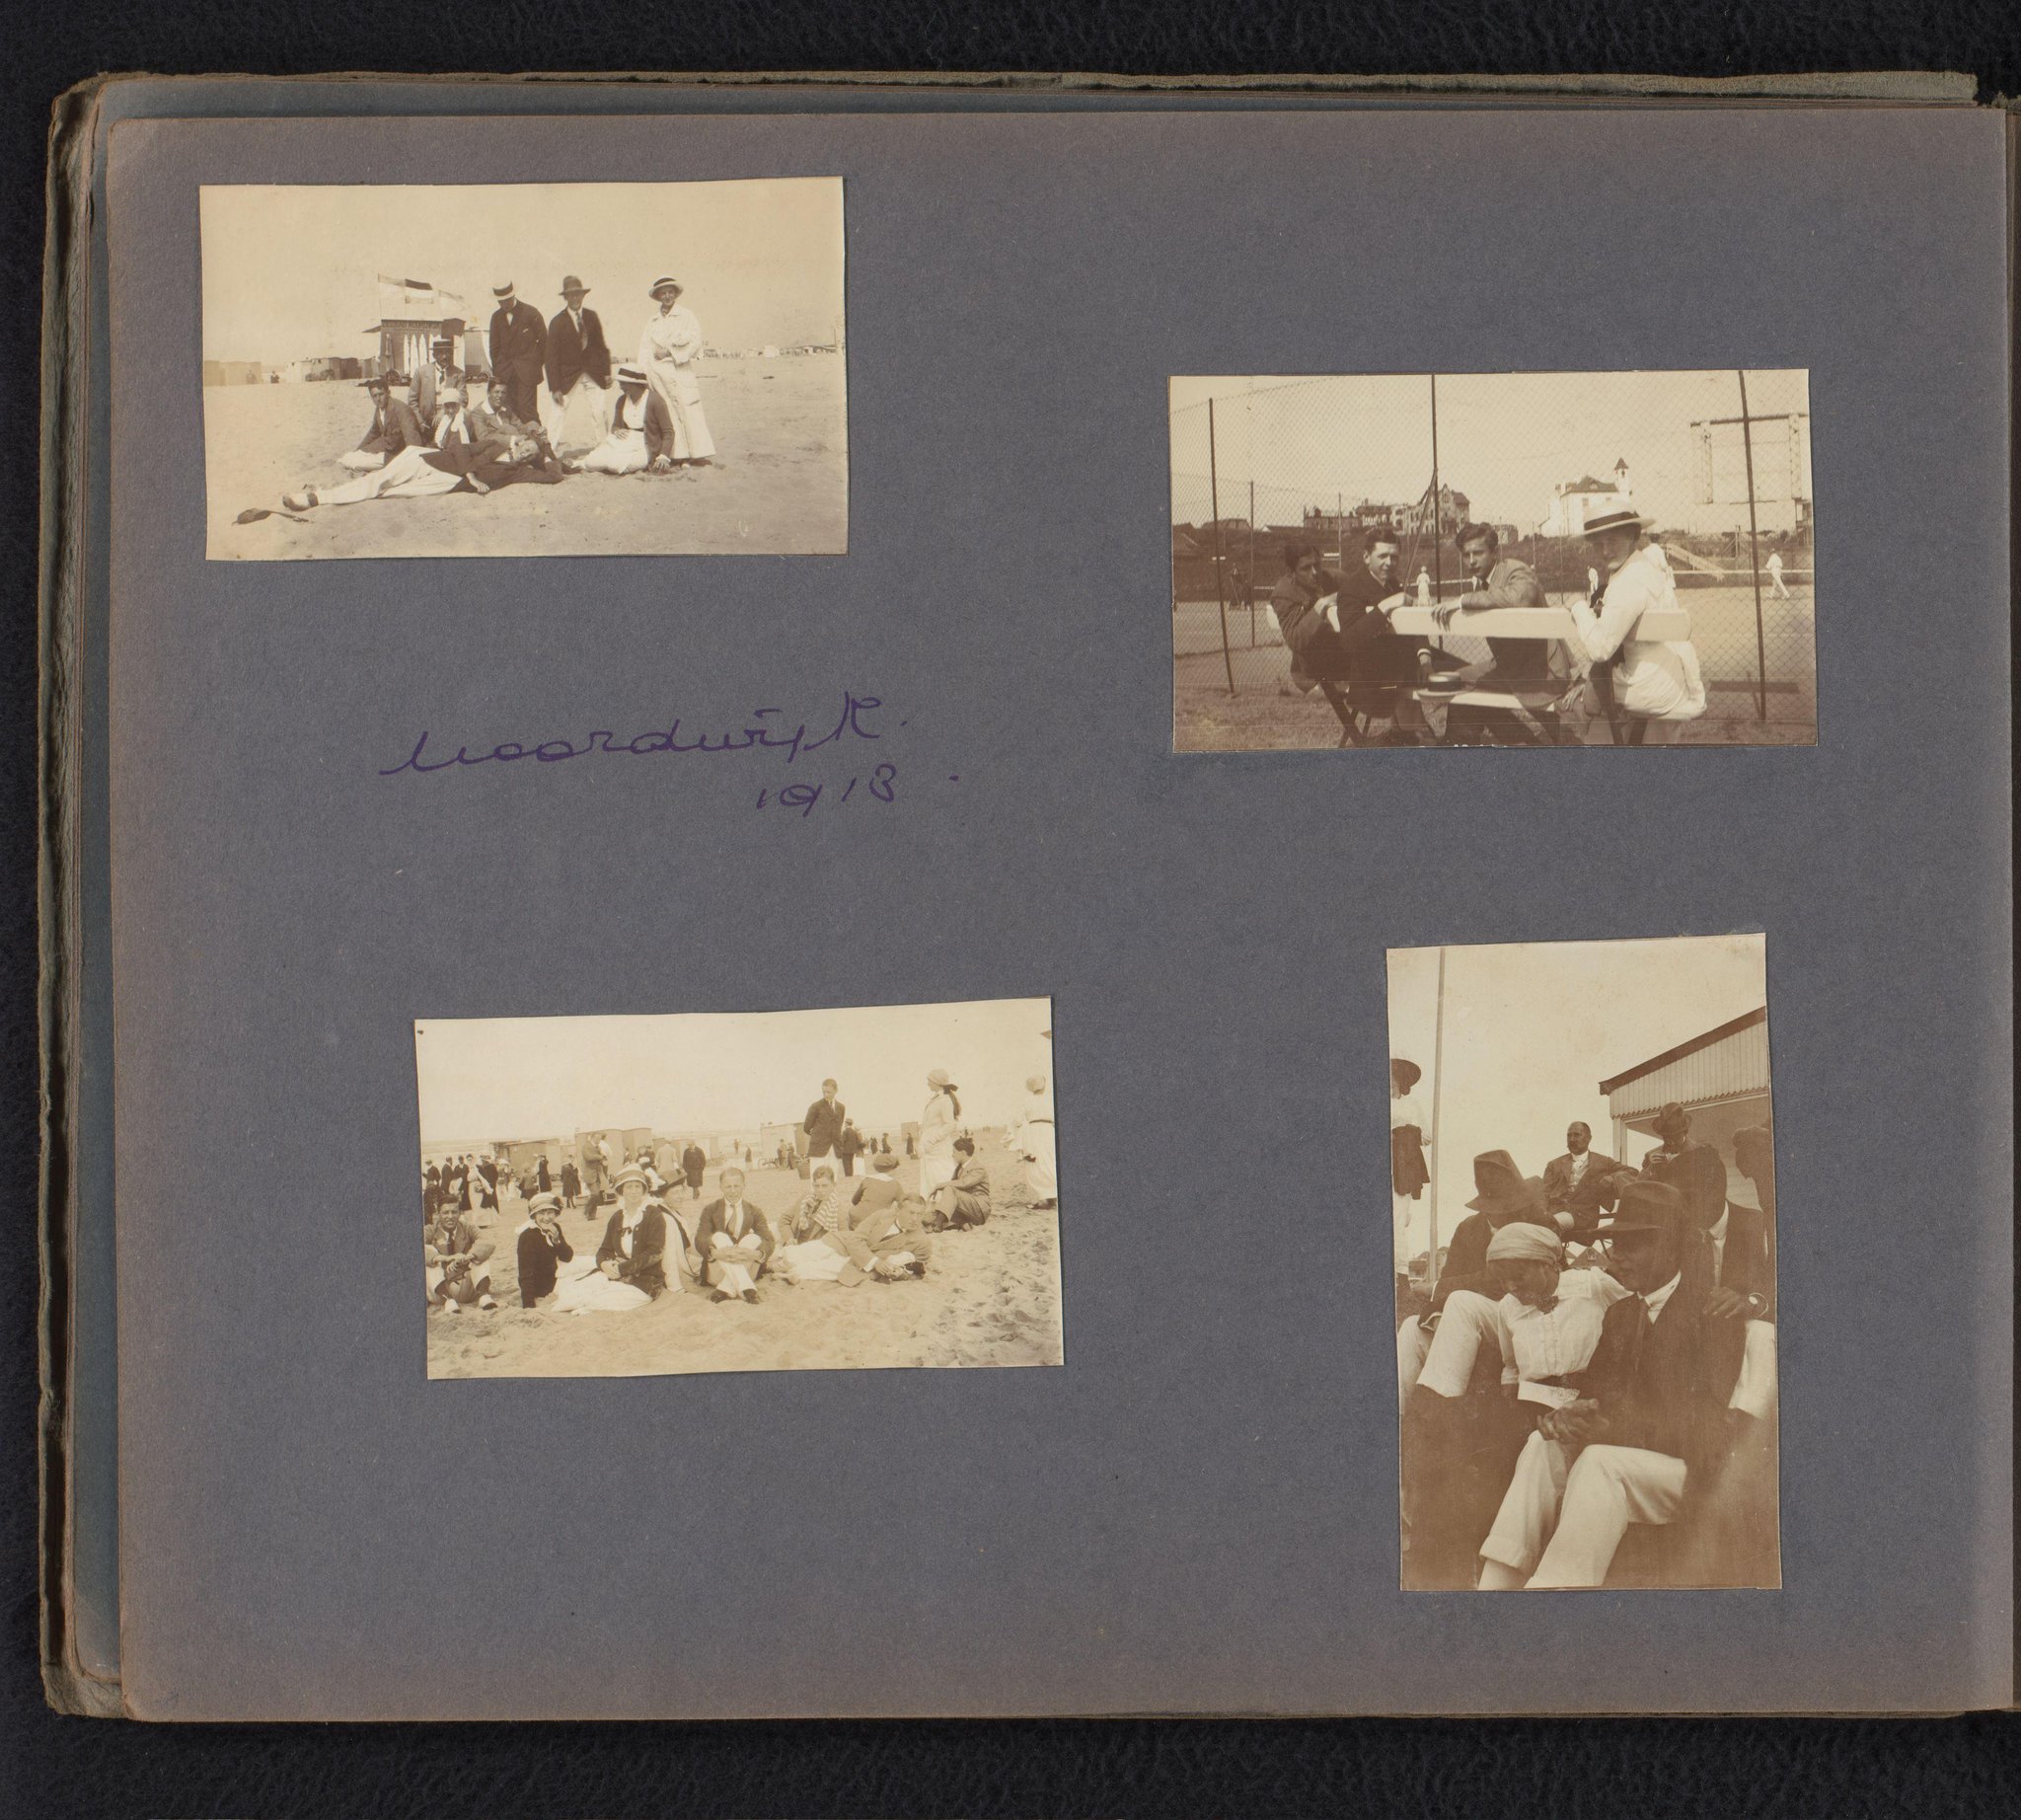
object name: album leaf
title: Vriendengroep op het strand van Noordwijk en op een tennisbaan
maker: Anonymous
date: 1913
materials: paper, cardboard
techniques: gelatin silver print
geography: noordwijk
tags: beach (as place of recreation), tennis, lawn-tennis, anonymous historical person portrayed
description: Deze foto's zijn onderdeel van een album.